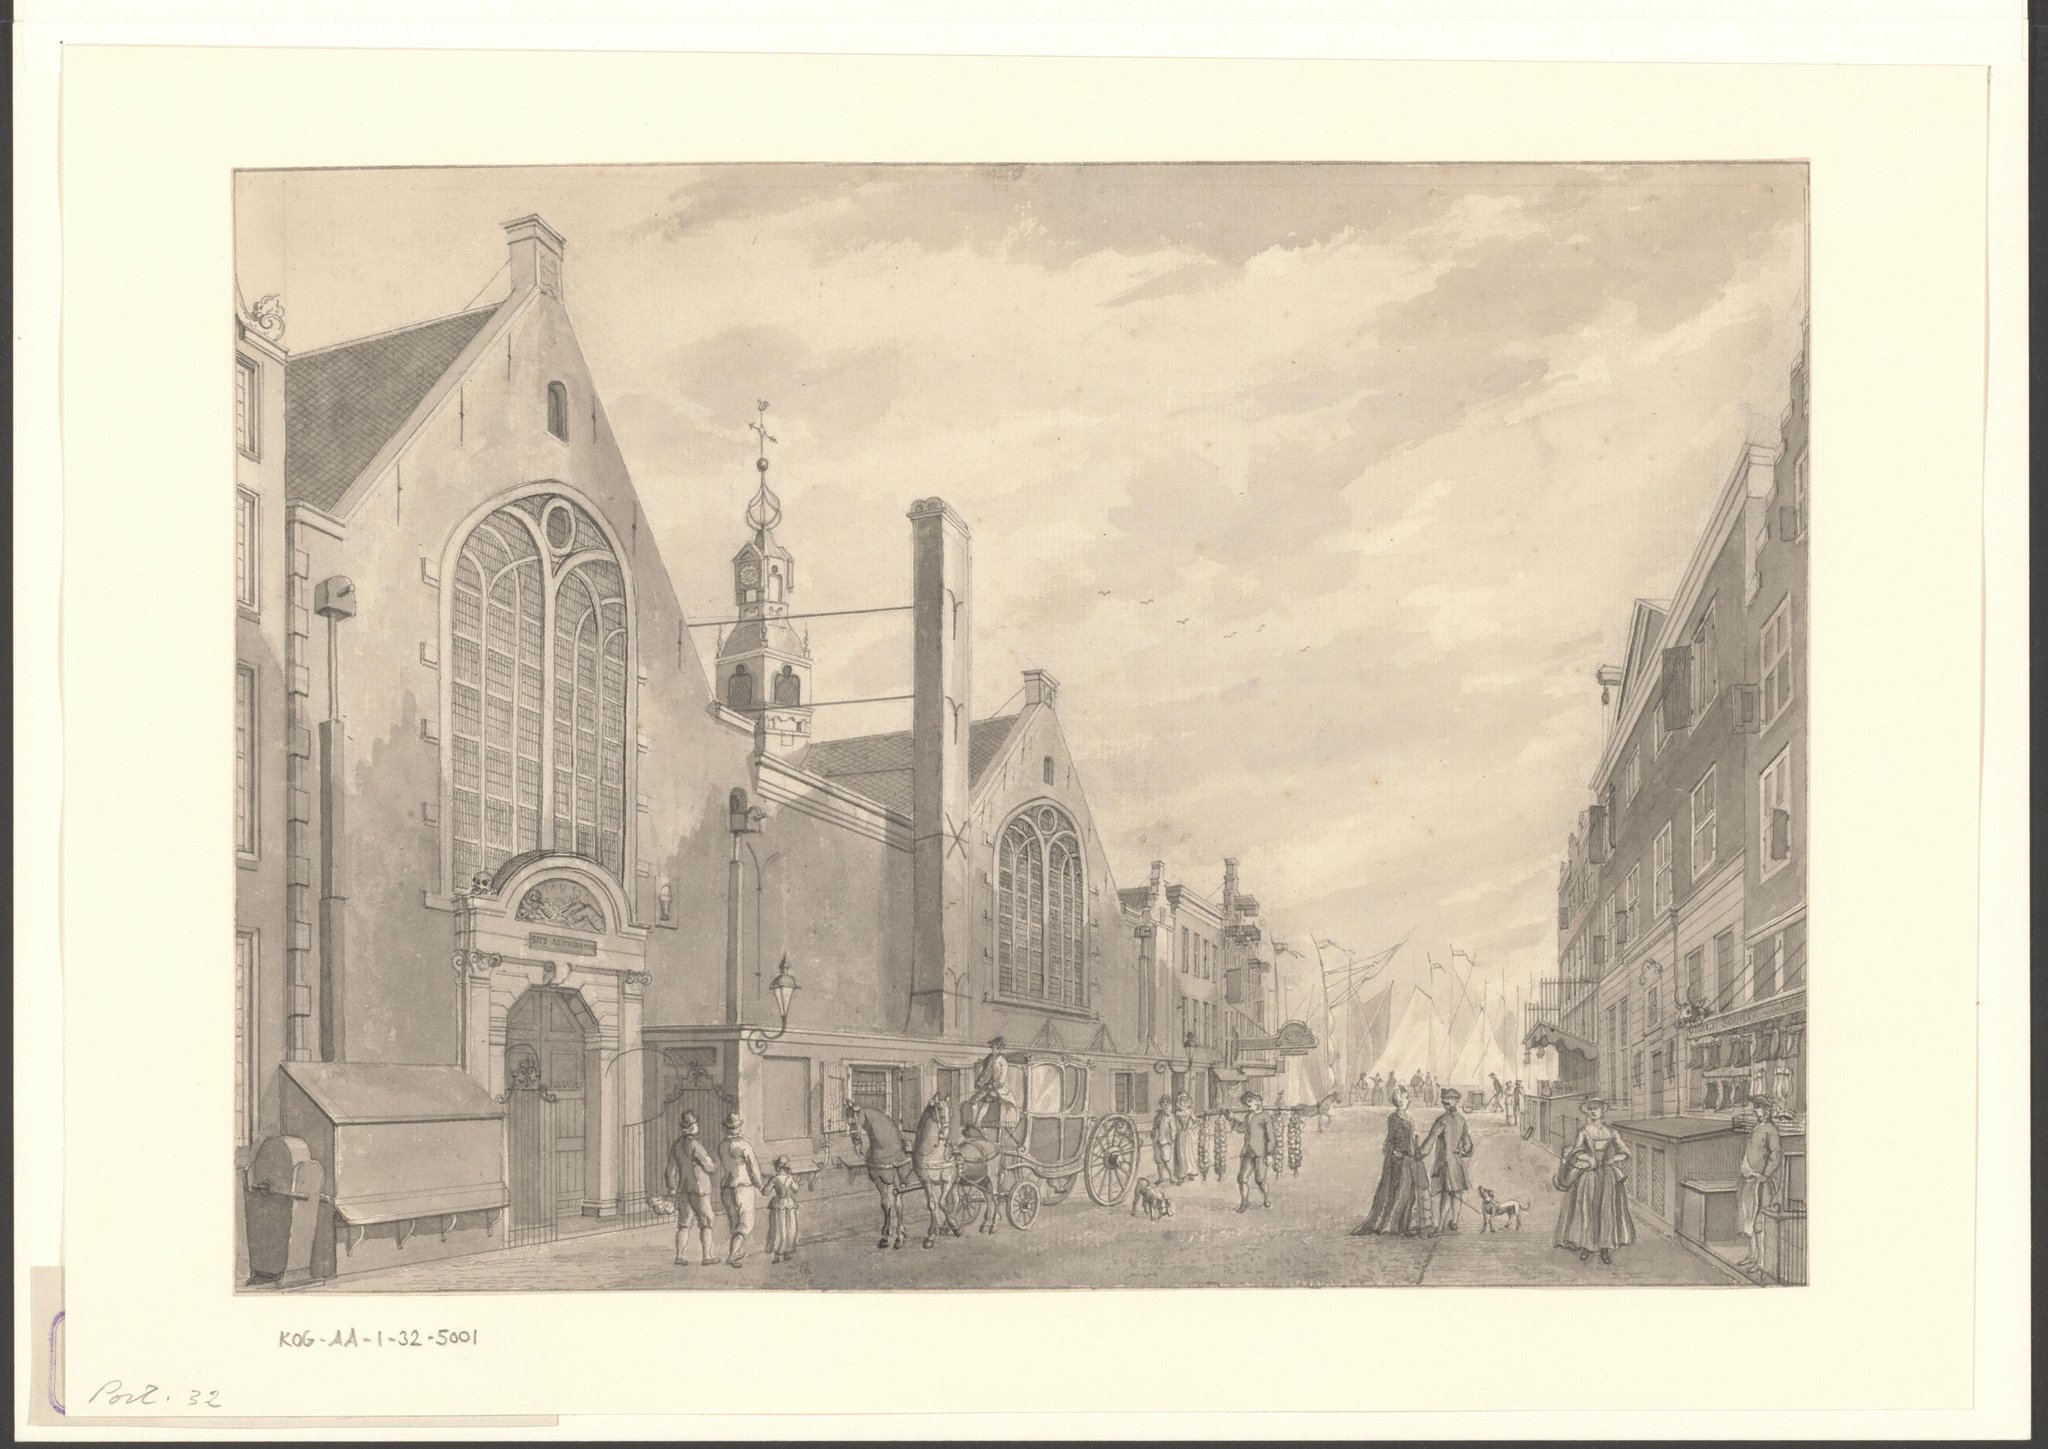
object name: drawing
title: Gezicht op de Oudezijds Kapel aan de Zeedijk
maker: hermanus petrus schouten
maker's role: draughtsman, painter, print maker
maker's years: 1747-1822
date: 1757-1822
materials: ink, paper, pencil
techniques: brush, pen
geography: amsterdam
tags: city-view in general; 'veduta', church (exterior), street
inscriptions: inscription: ‘Geschenk v/d Heer (...) voor de Fouquetprent’, inscription: ‘Port. 32’, collector's mark: ‘32’ Lugt 1641b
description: Onderwerpsrubriek binnen de Atlas Amsterdam: Oudezijds Kapel.